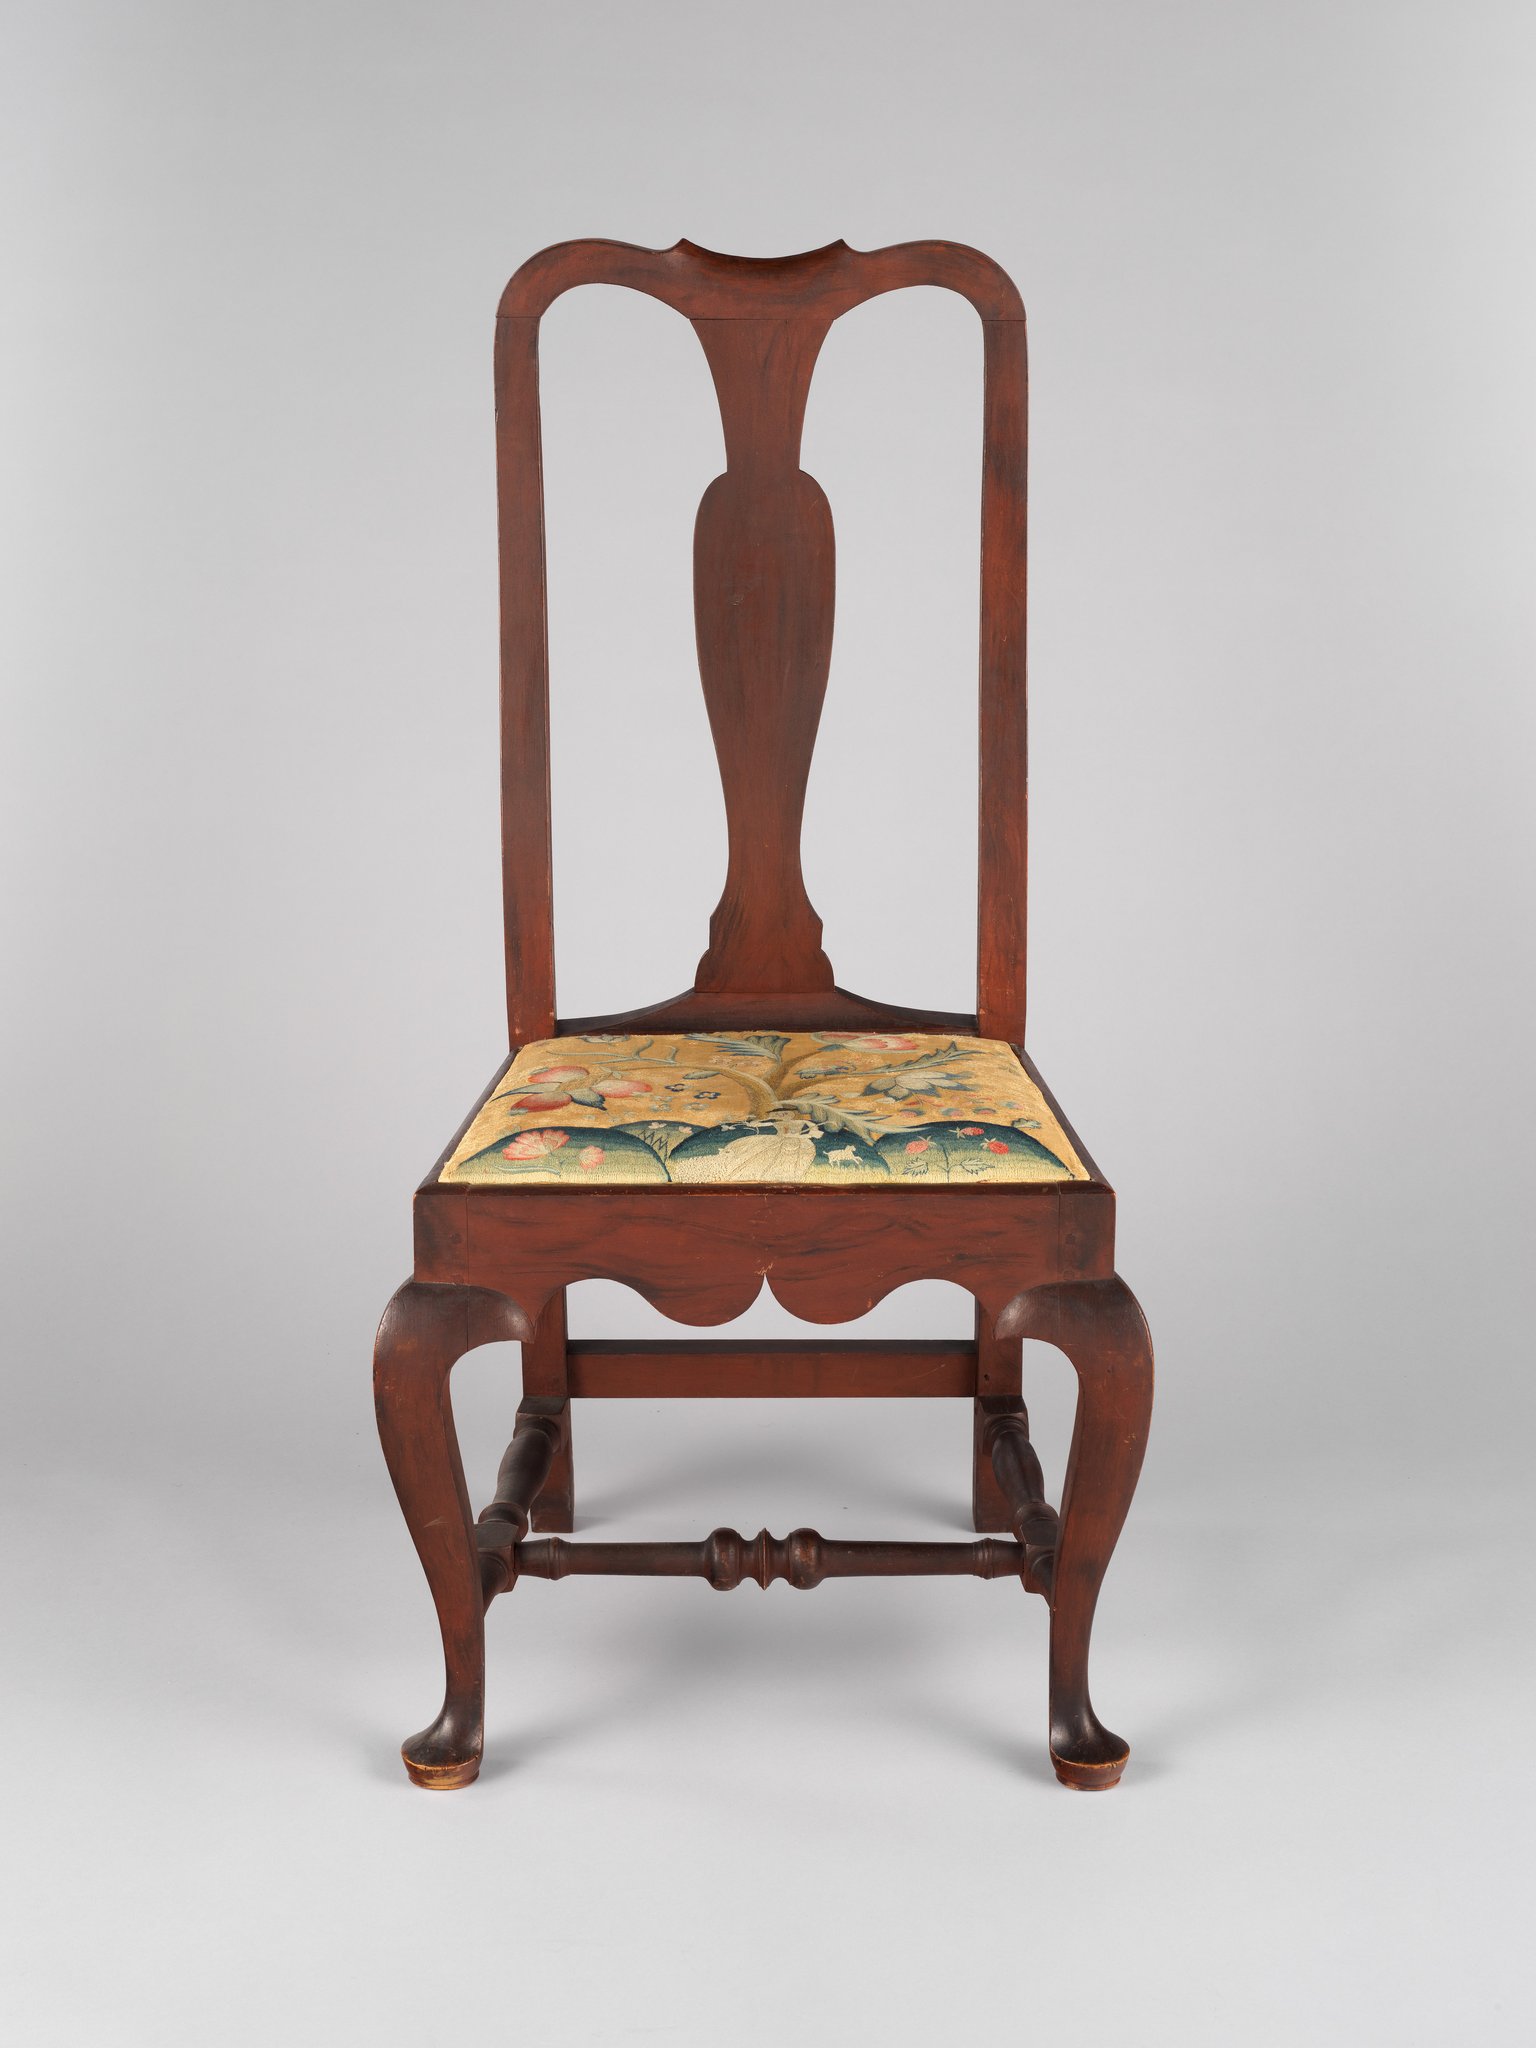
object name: side chair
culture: american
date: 1735-1760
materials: linen, wood, wool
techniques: painting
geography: united states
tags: squirrels,flowers,trees